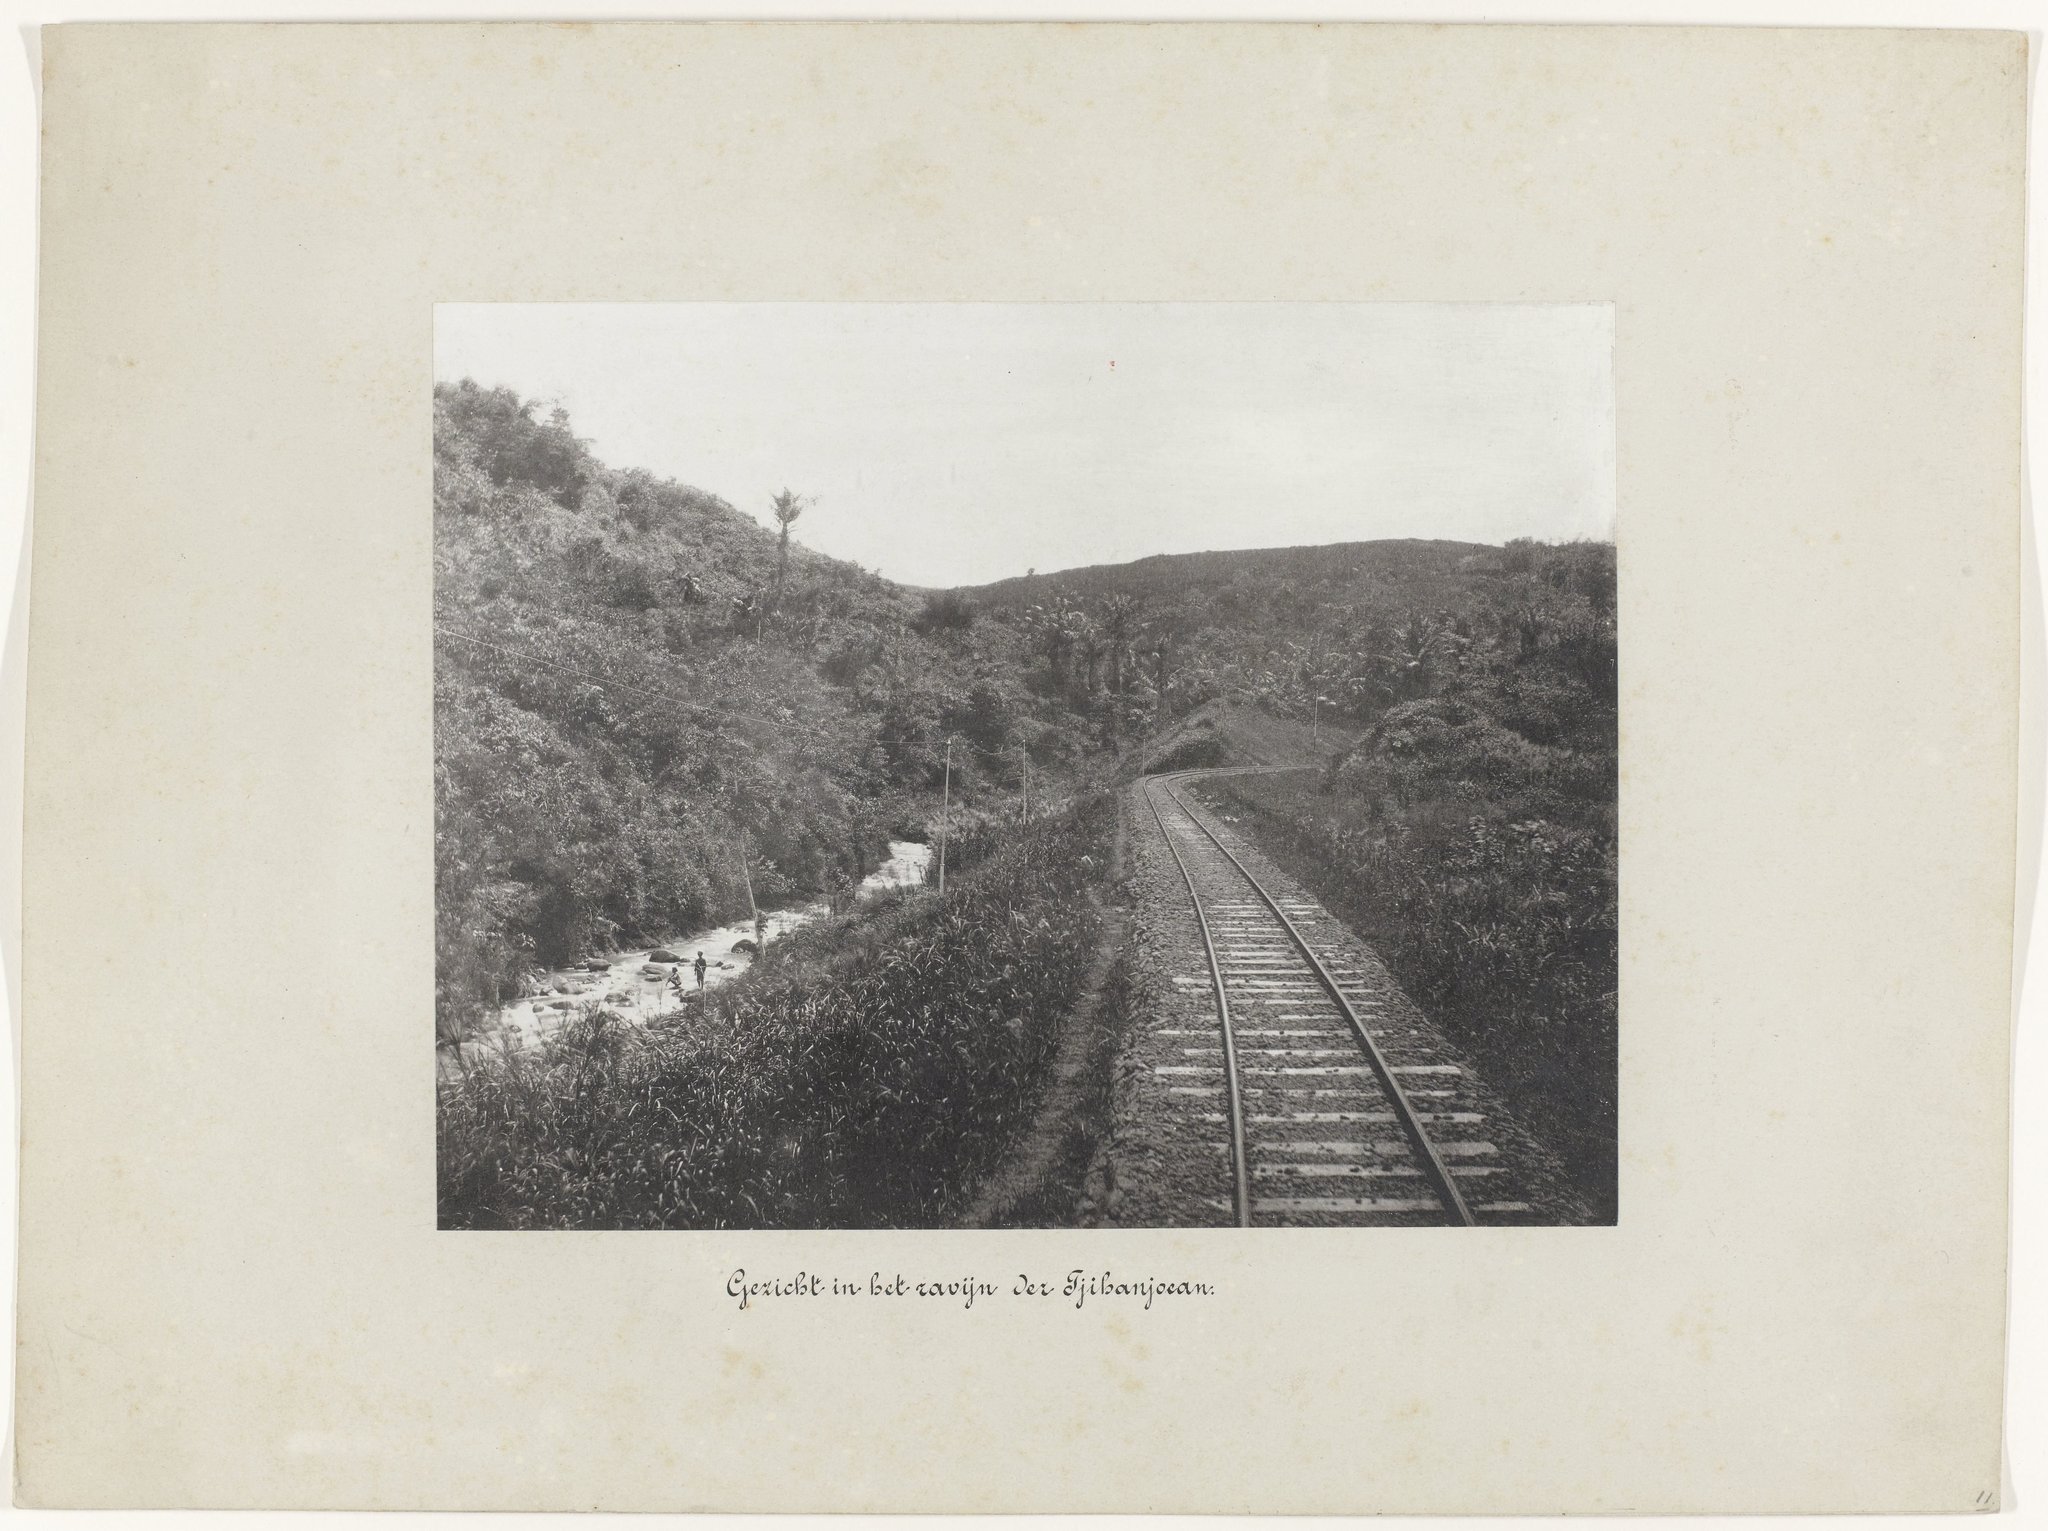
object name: photograph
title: Staatsspoorwegen op Java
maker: Anonymous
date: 1880-1888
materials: photographic support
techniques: photography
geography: java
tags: java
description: Gezicht op de spoorweg langs de rivier en het ravijn van de Tjihanjoean. Onderdeel van een groep van 62 foto's in een doos met het opschrift "Staatsspoorwegen op Java" uit 1888.